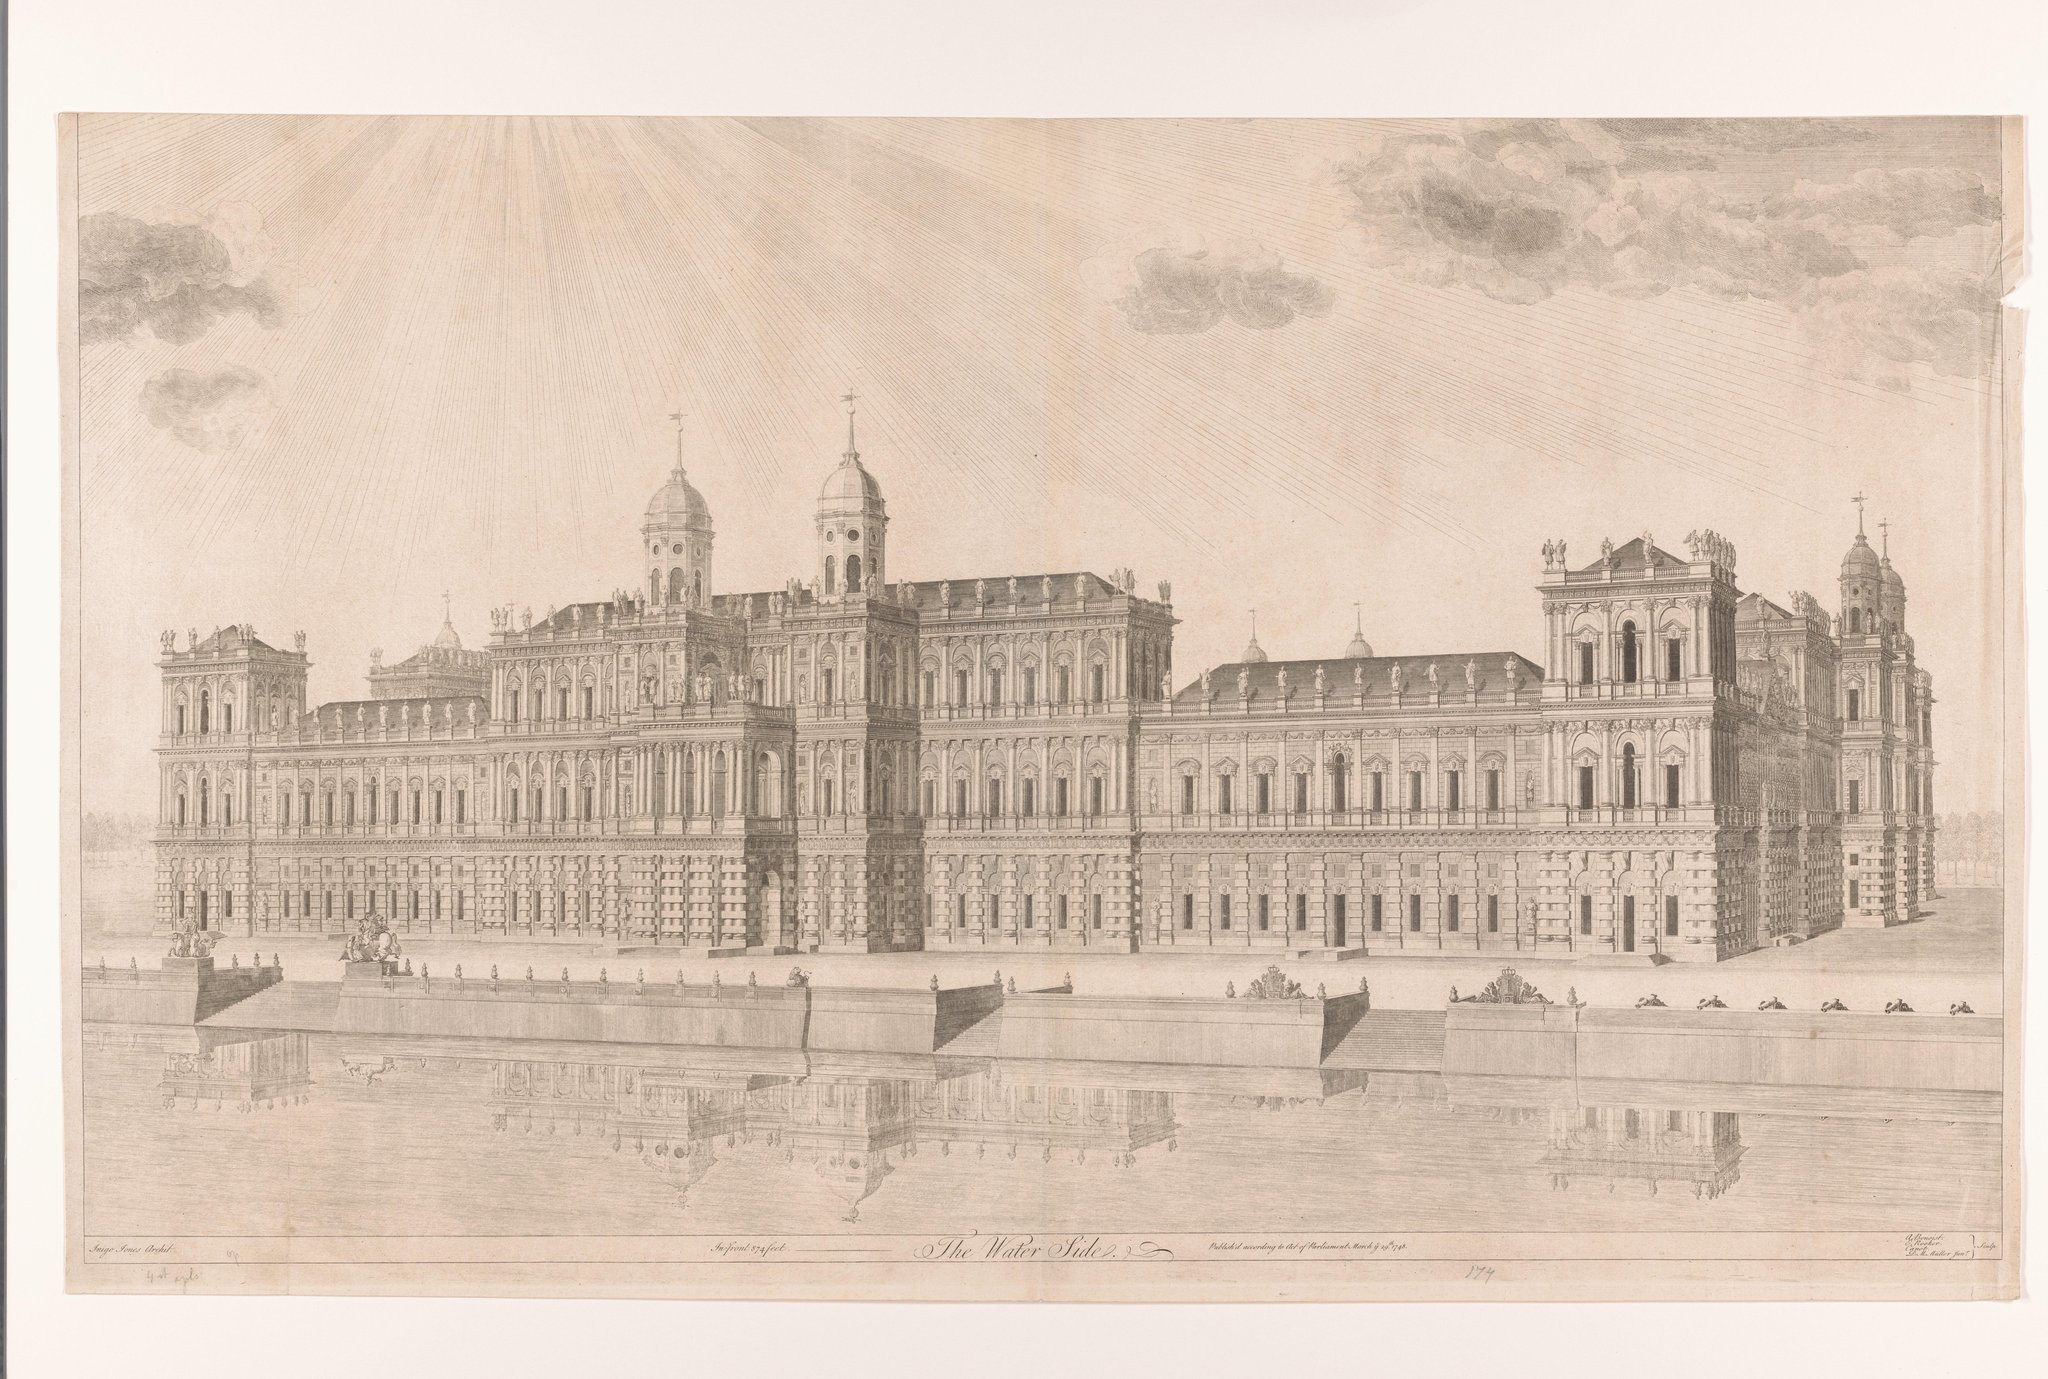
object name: print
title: Gezicht op het Palace of Whitehall, gezien vanaf het water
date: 1748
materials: paper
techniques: etching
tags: palace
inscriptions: collector's mark: Lugt 2228